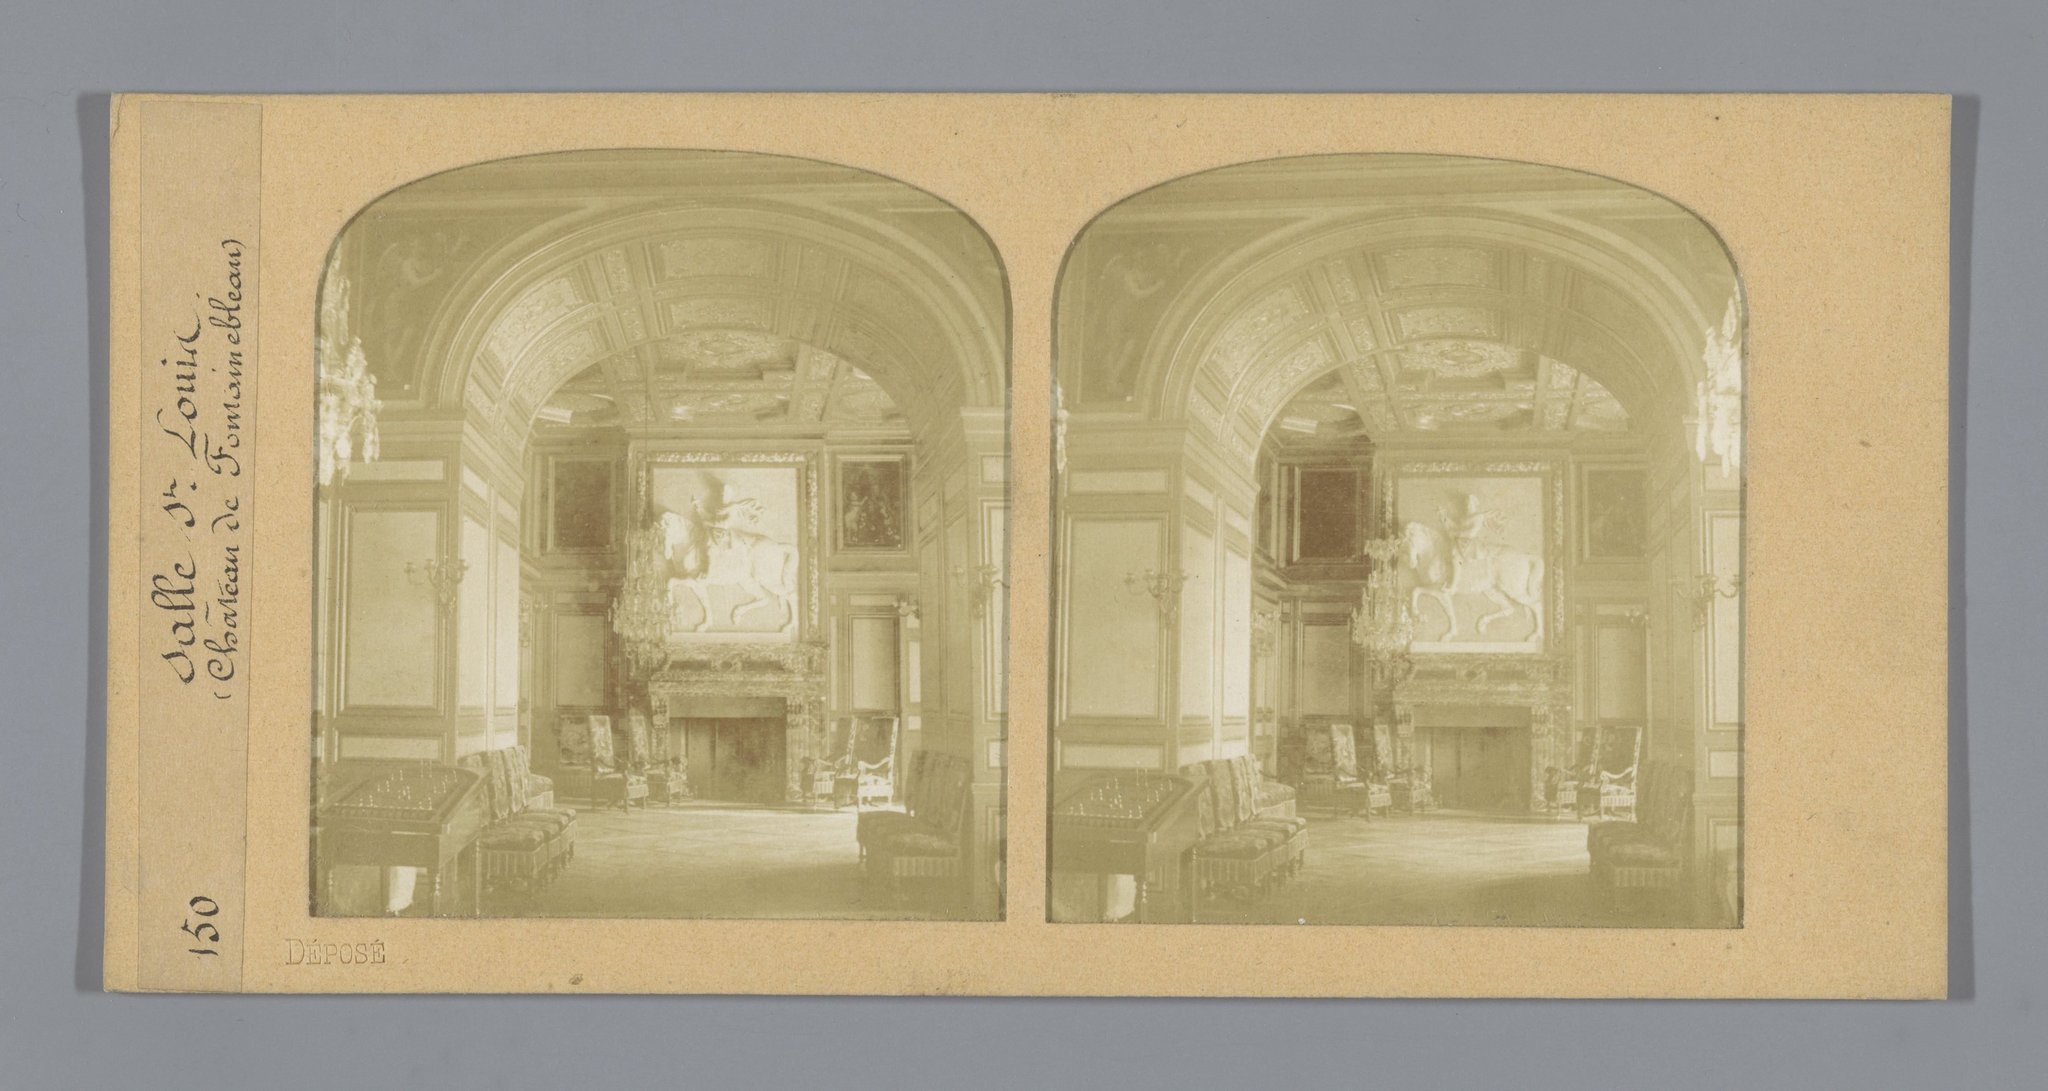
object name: tissue stereograph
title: Zaal van Saint-Louis in het kasteel van Fontainebleau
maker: florent grau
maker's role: manufacturer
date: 1858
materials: cardboard, paper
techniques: albumen print, hand coloring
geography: fontainebleau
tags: living-room, parlour, sitting-room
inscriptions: number: ‘150’, inscription: ‘Déposé’